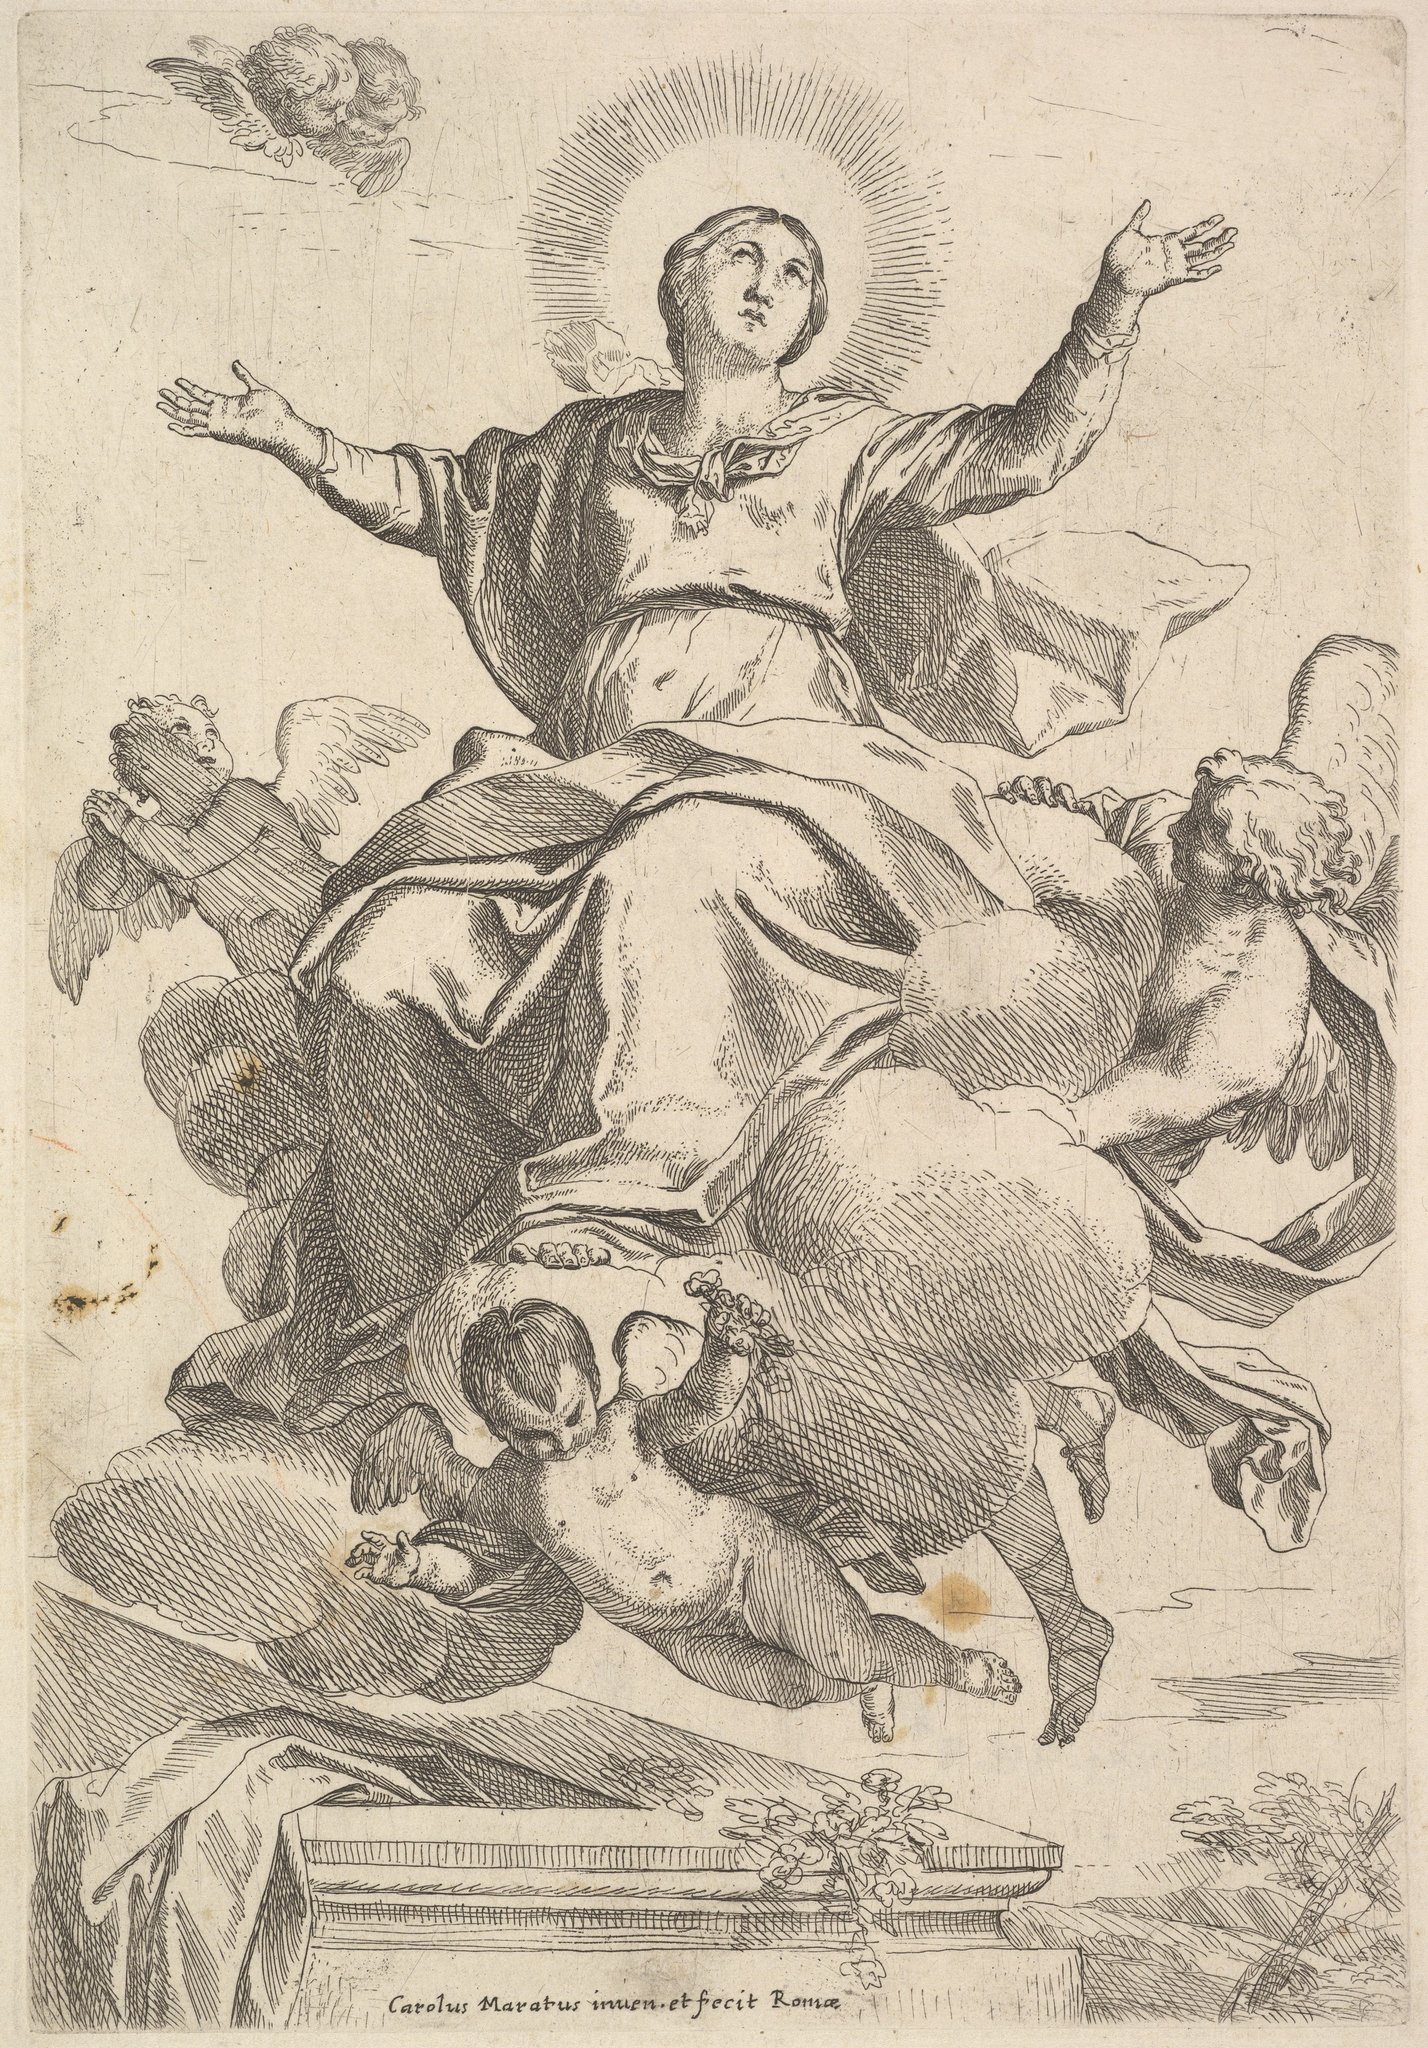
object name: print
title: The Assumption of the Virgin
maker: carlo maratti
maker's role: artist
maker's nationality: italian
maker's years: 1625-1713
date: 1601-1700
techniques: etching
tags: angels,assumption of the virgin